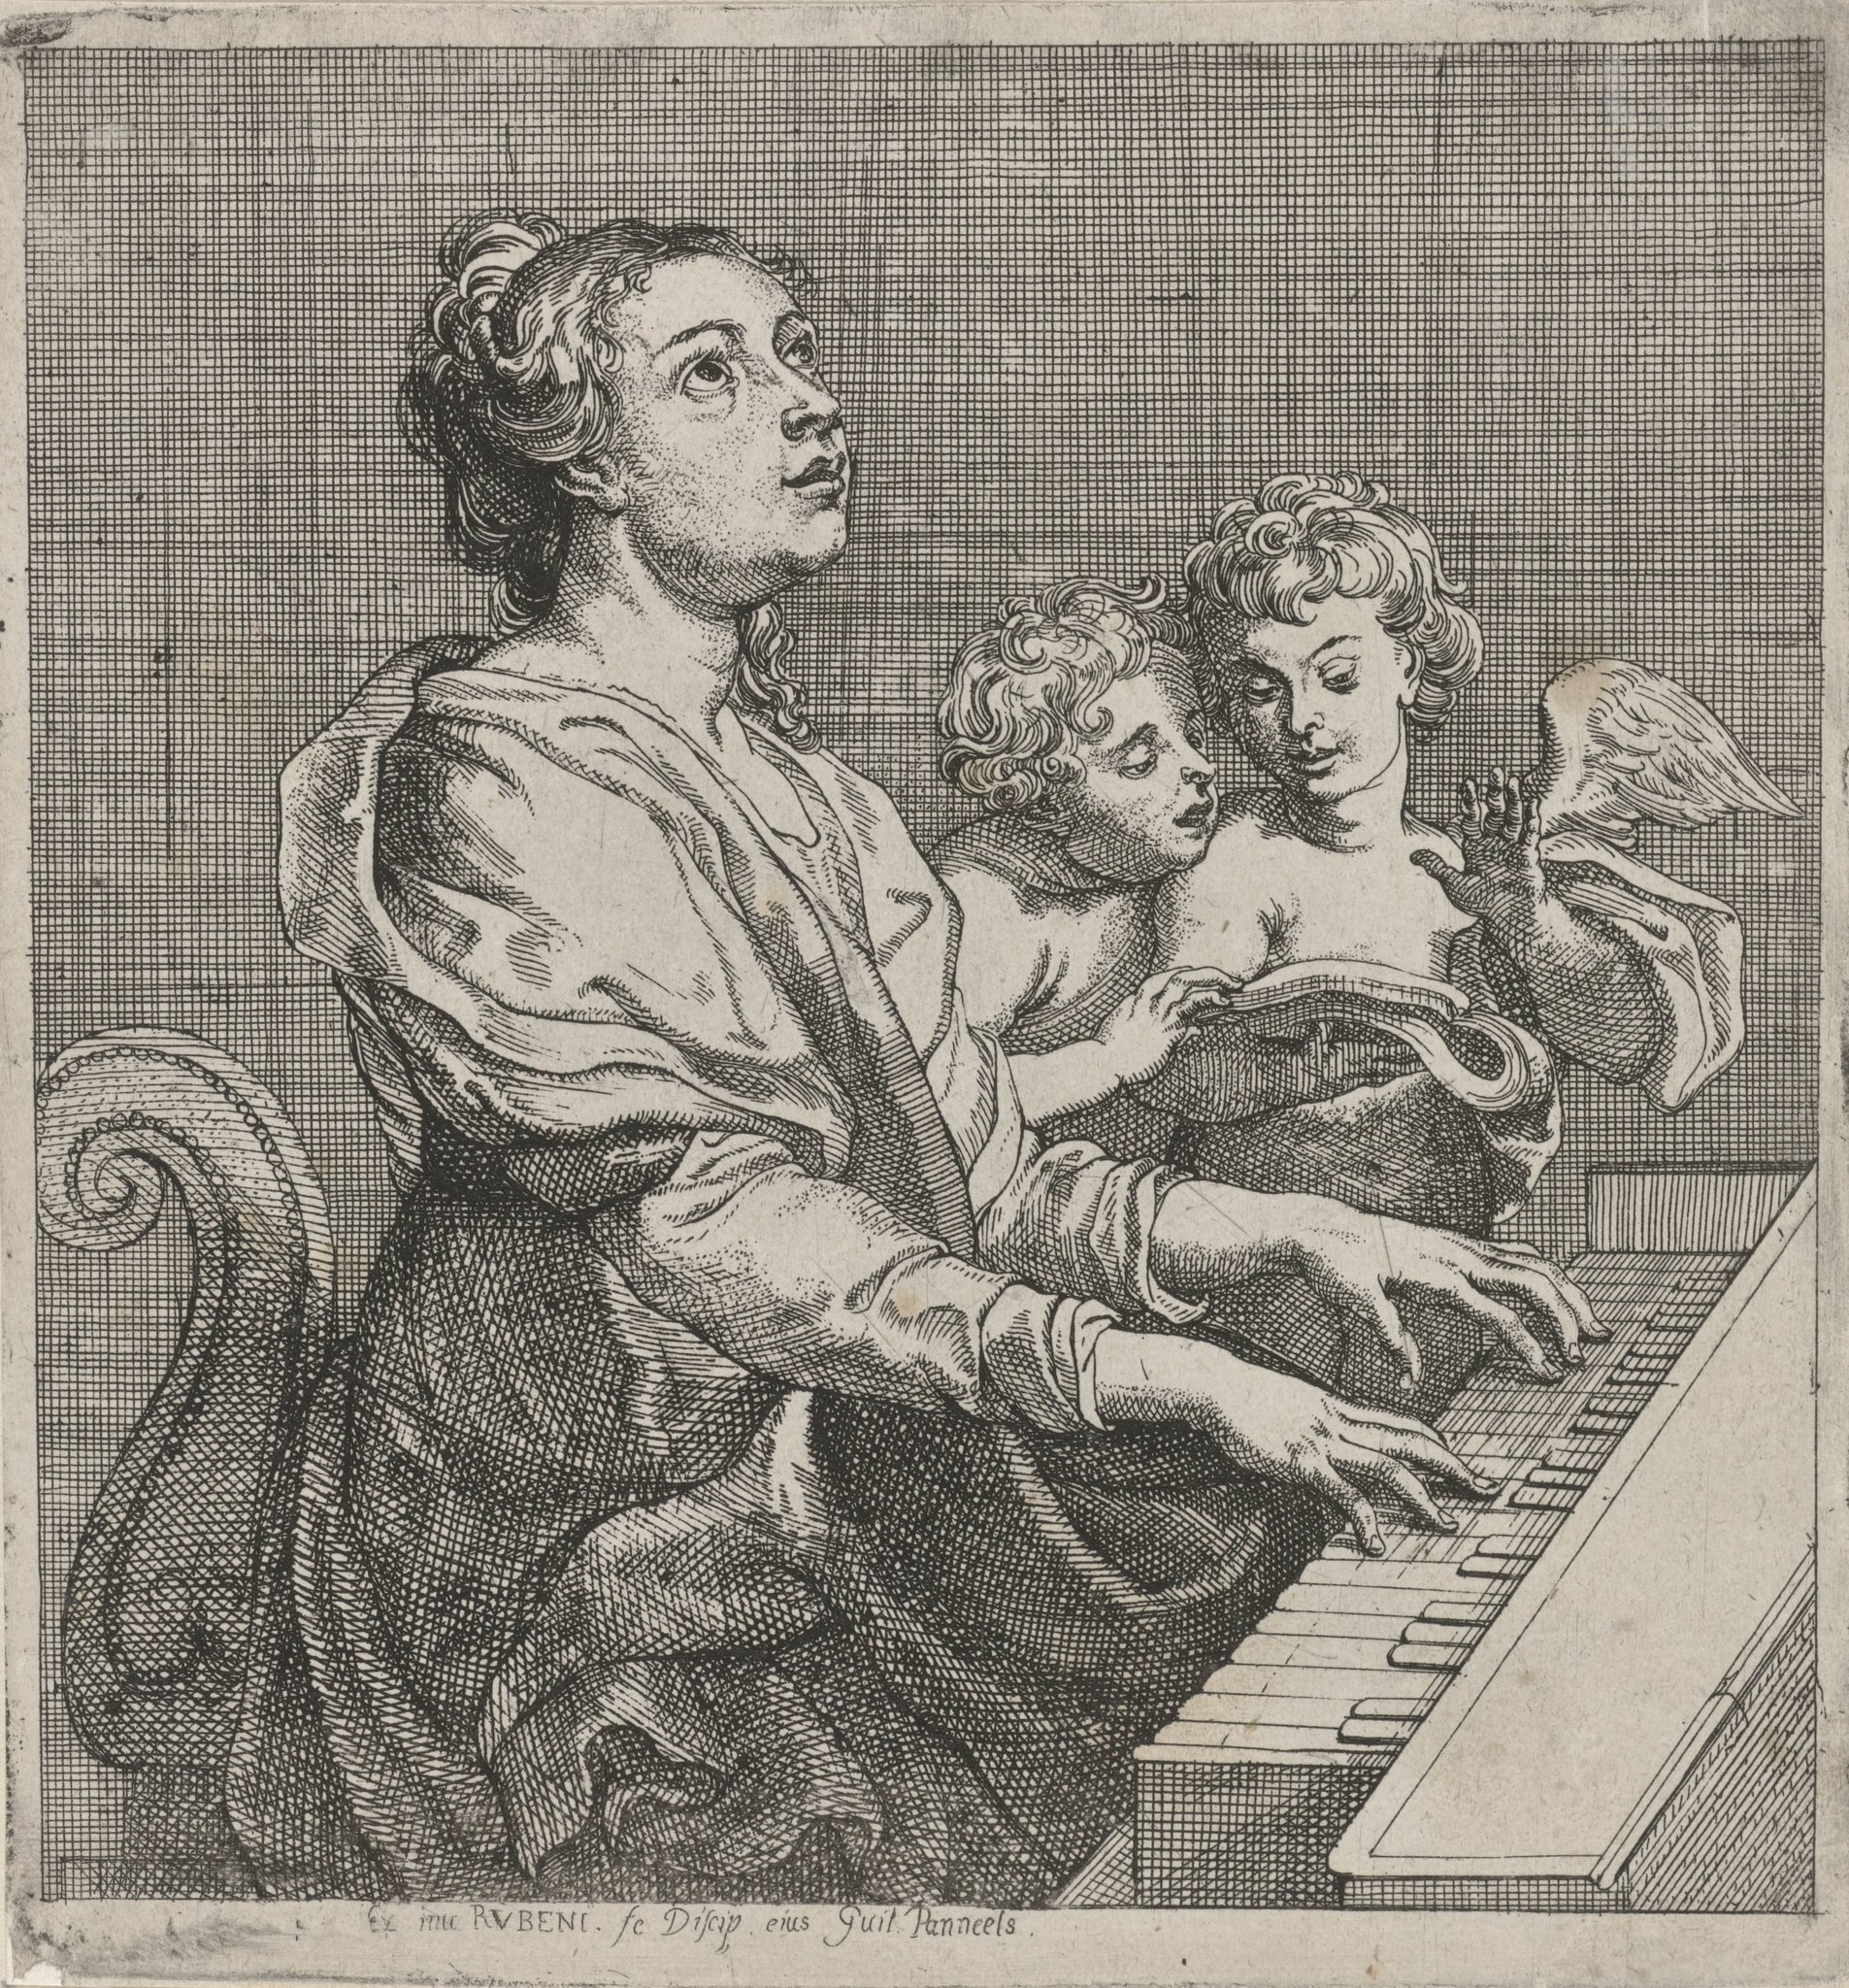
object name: print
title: H. Cecilia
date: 1610-1634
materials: paper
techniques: engraving, etching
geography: antwerp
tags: the virgin martyr cecilia of rome; possible attributes: falcon, musical instruments, organ, wreath of roses and lilies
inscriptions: collector's mark: Lugt 240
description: De H. Cecilia bespeelt een orgel. Ze wordt vergezeld door twee engelen.